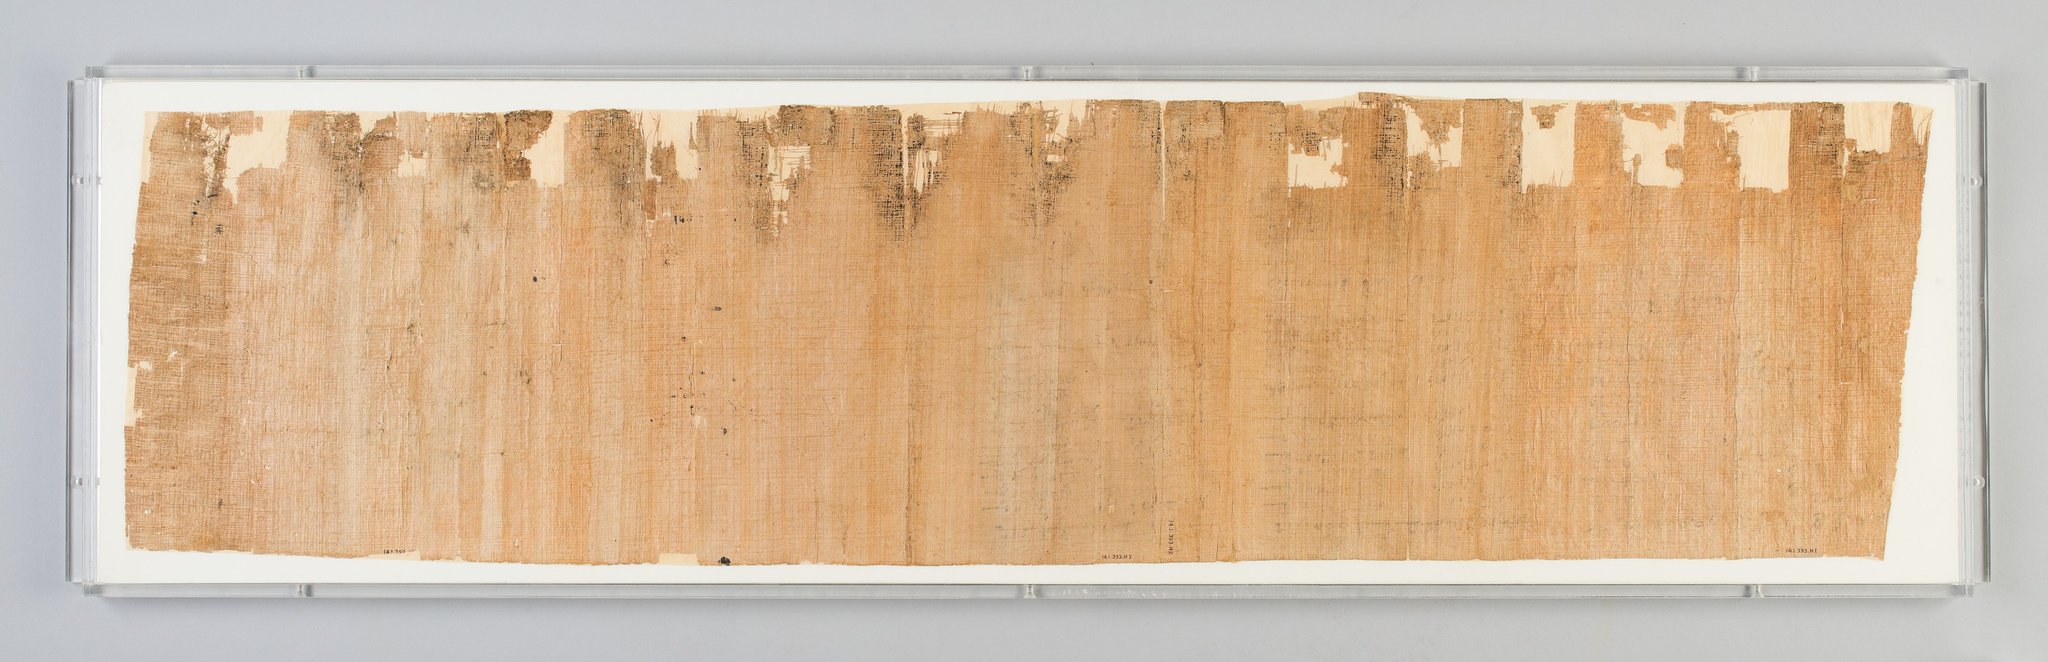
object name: papyrus, uninscribed, blank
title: Papyrus sheet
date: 664-332 BCE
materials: papyrus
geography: egypt